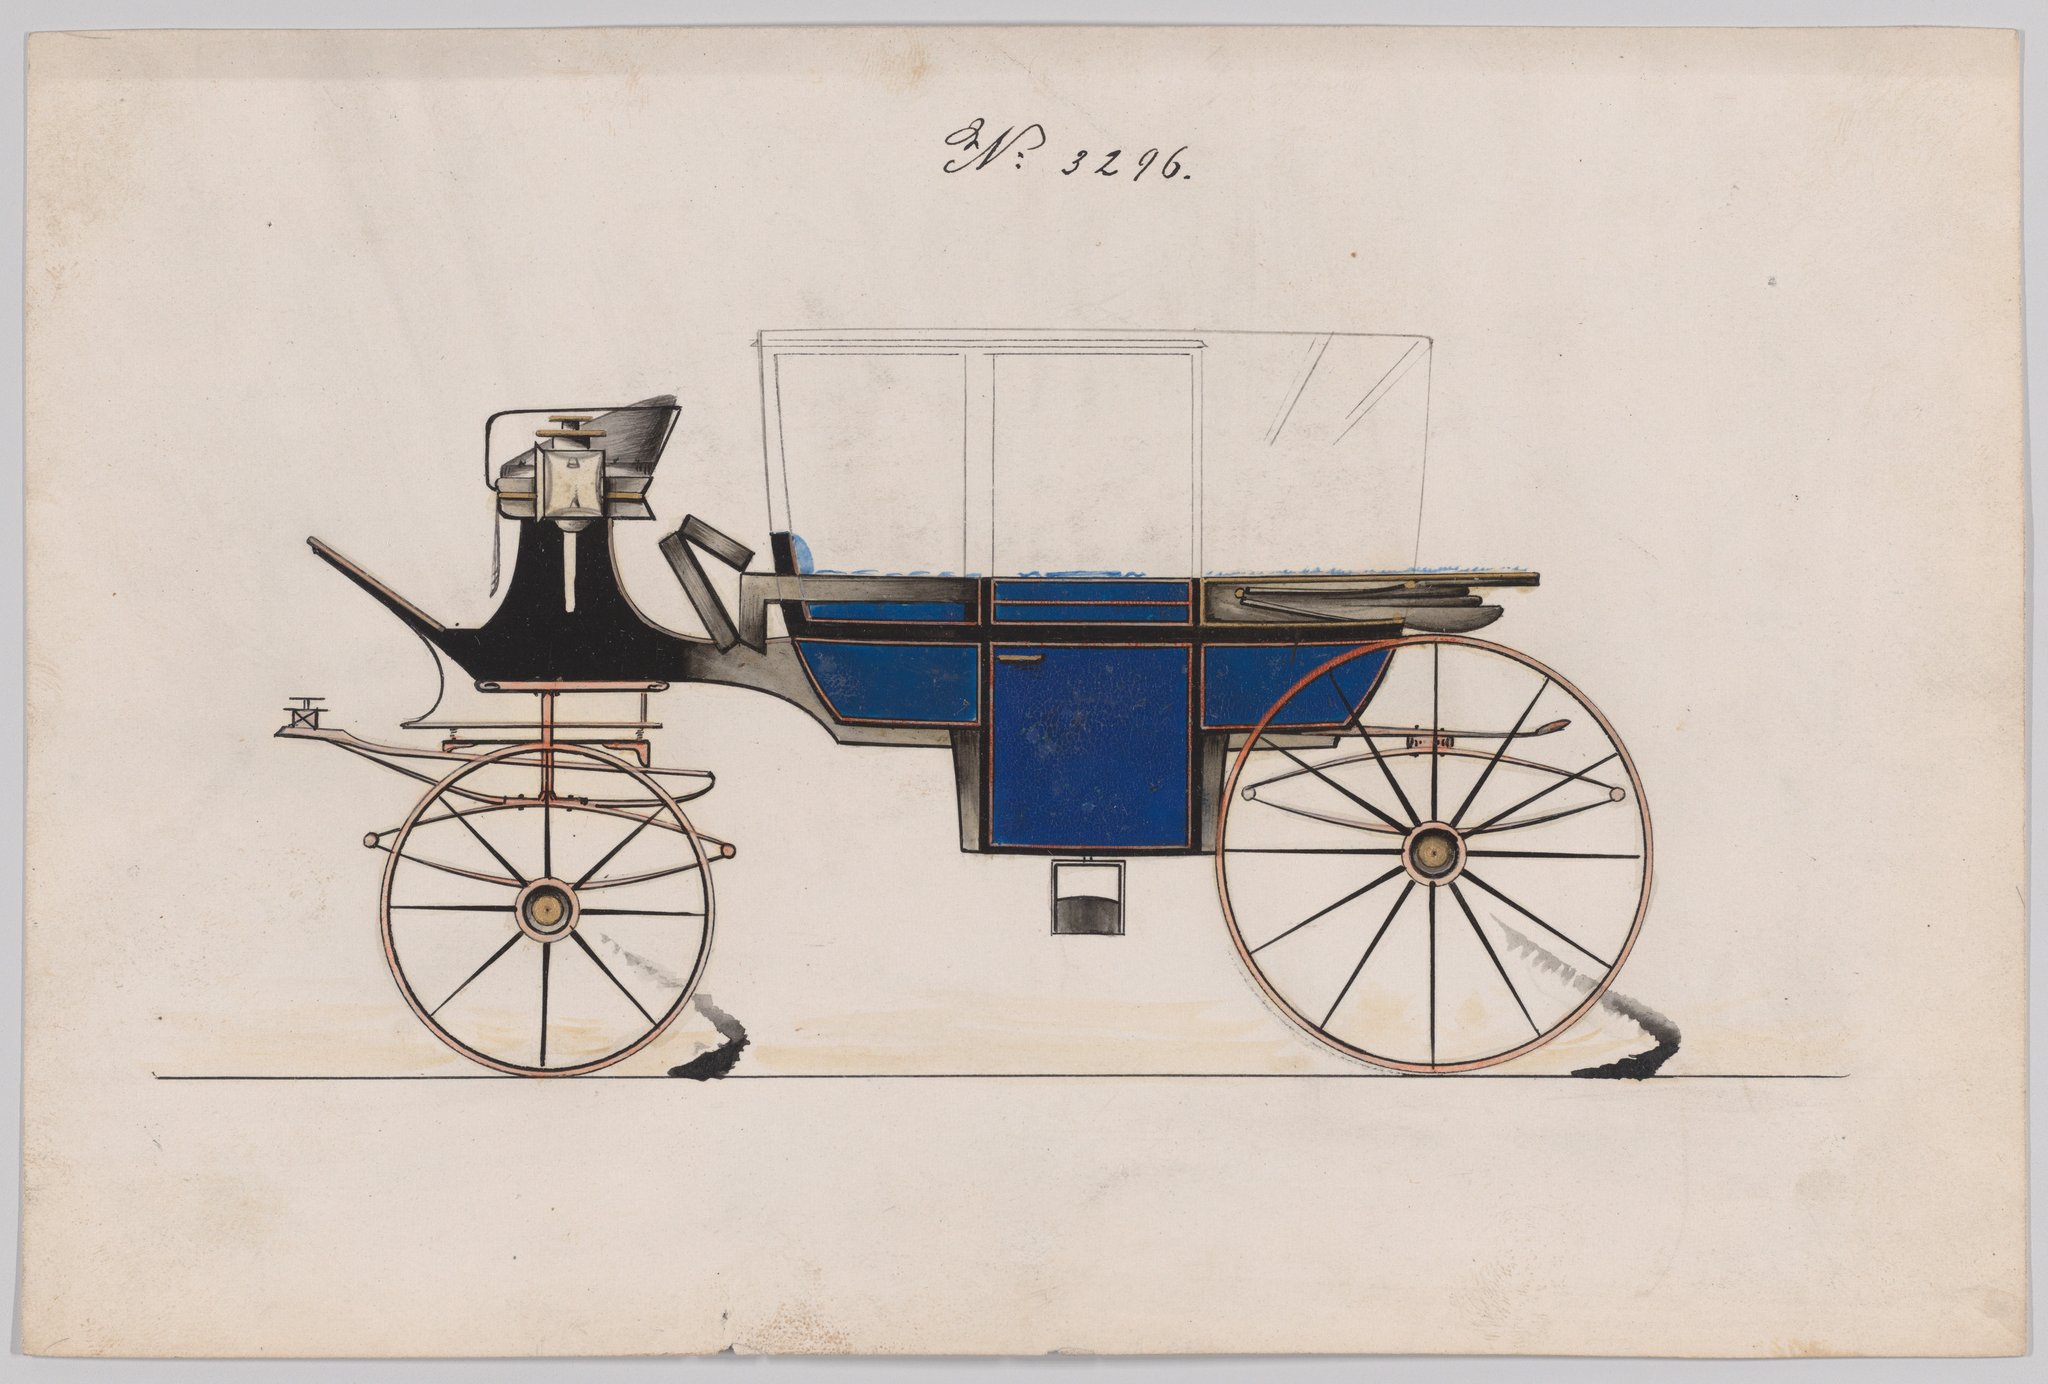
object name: drawing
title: Design for Landau, No. 3296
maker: brewster & co.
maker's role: manufacturer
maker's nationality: american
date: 1877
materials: gouache, gum arabic, ink, watercolor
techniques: pen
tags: carriages